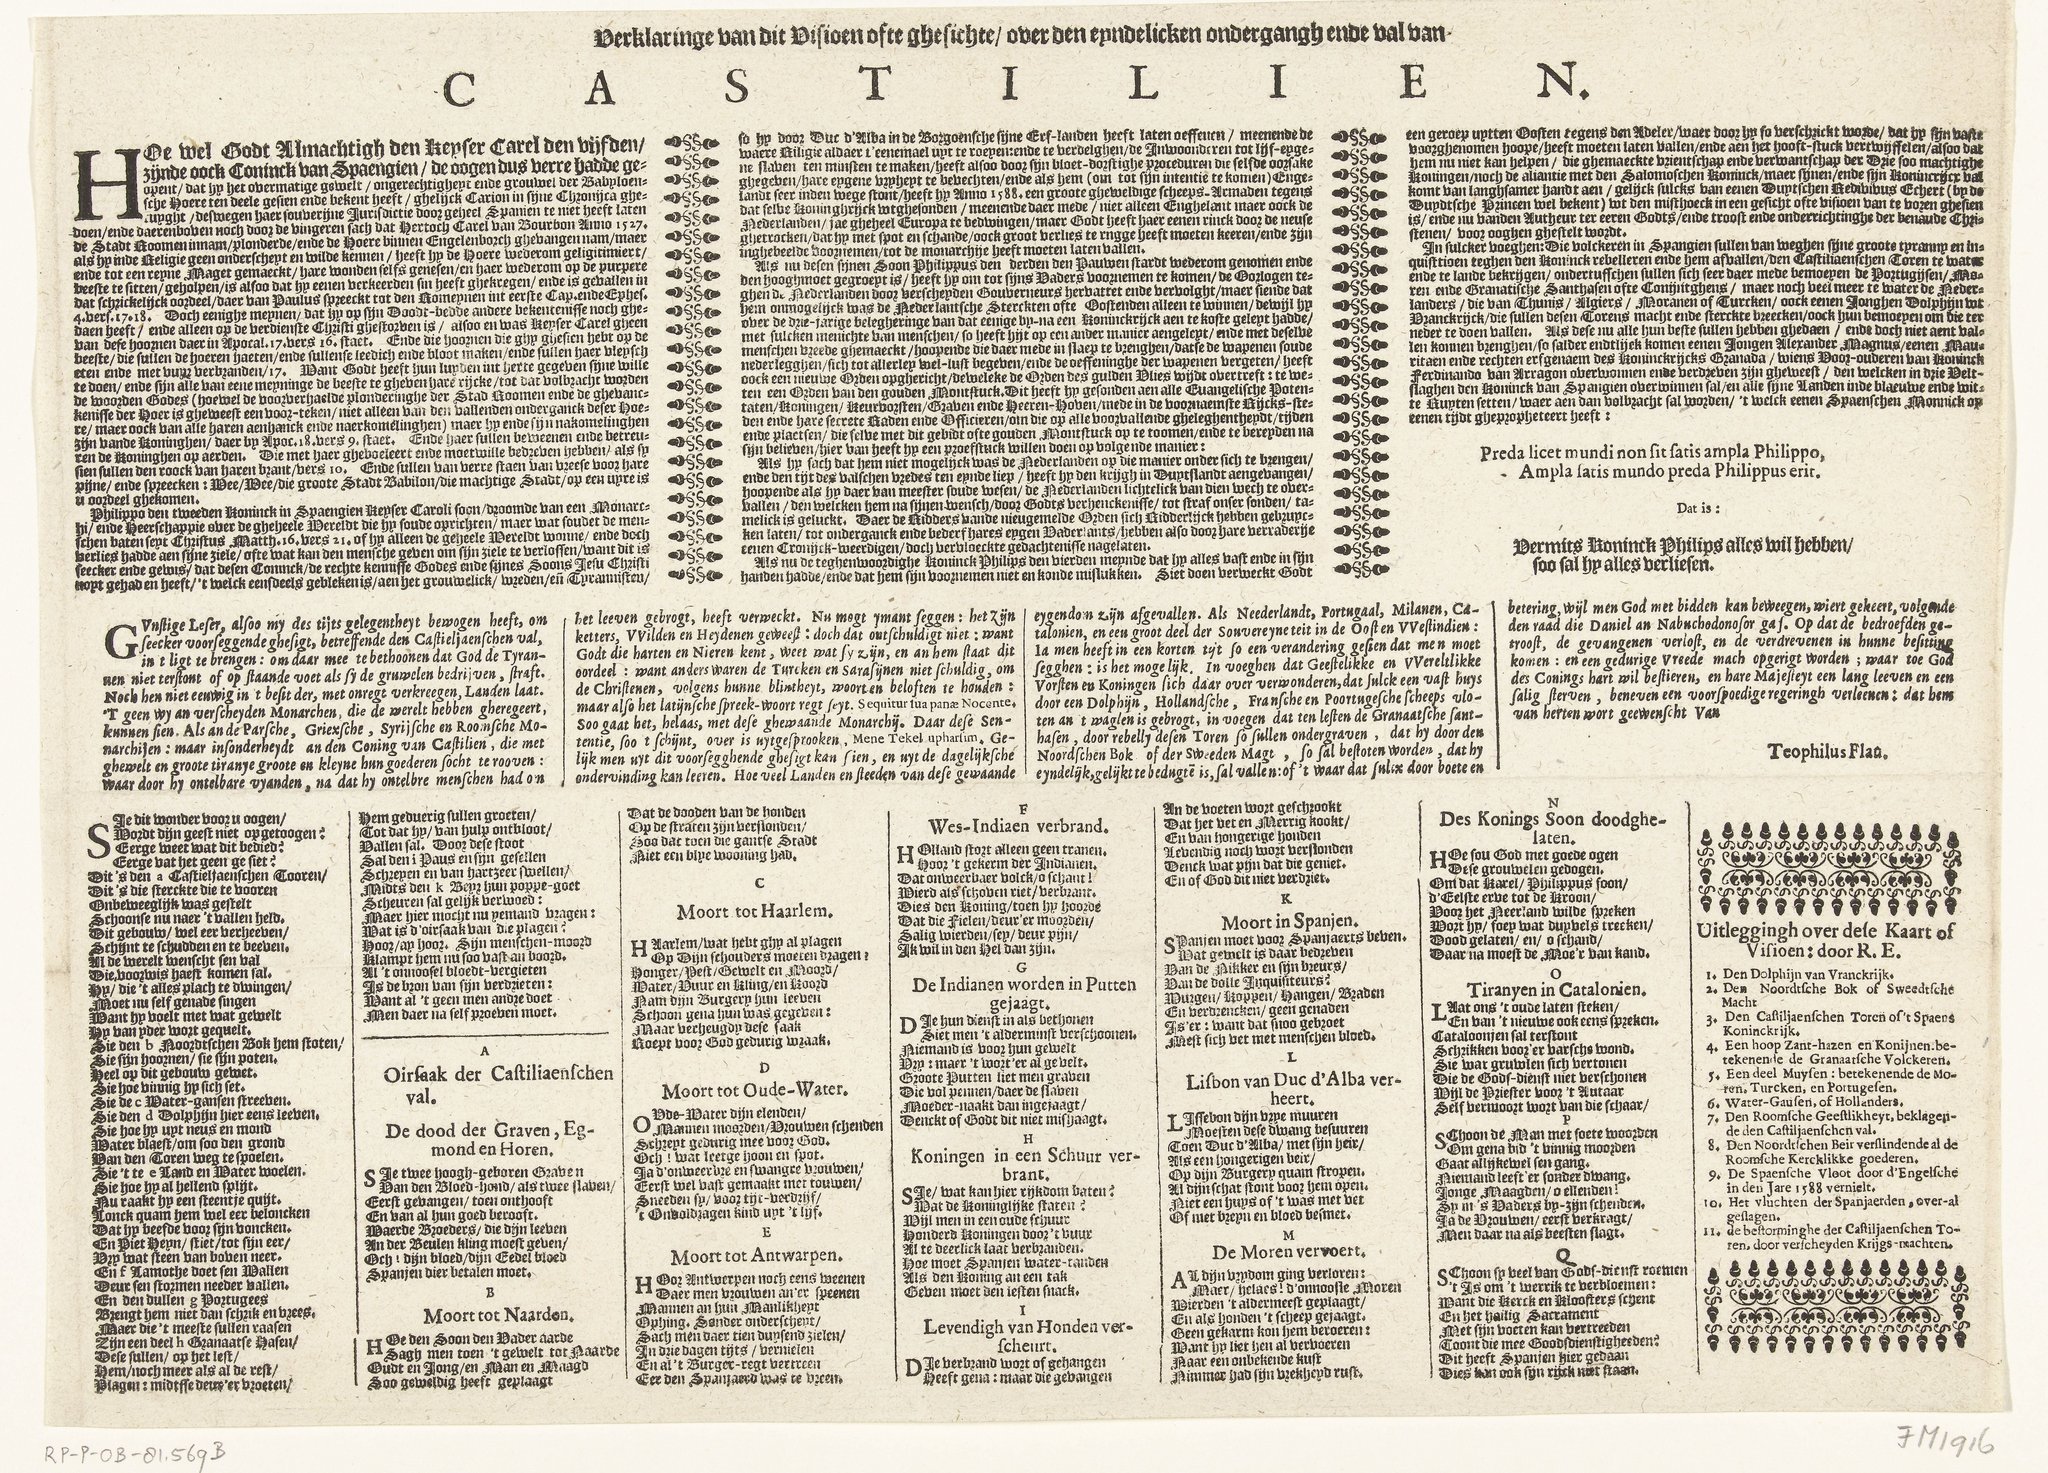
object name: text sheet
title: Tekstblad bij de prent van het visioen van de ondergang van Spanje, ca. 1630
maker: Anonymous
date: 1630-1635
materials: paper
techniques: letterpress printing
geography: northern netherlands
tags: filips iv (koning van spanje)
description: Muller ordende deze plaat eerst bij het jaar 1645. Volgens de beschrijving in het Supplement past de prent beter rond 1625 omdat de prent gebaseerd zou zijn op (of het origineel voor) de titelprent in: Nicolaas Jansz van Wassenaar, t' Achste deel of t' Vervolch van het Historisch Verhael aller gedenckwaerdiger geschiedenissen, die in Europa, als Duijtslant, Vranckrijck, Engelant ... Nederlant: in Asia ... in Africa ... in America ... van Octobri des jaers 1624. tot April des jaers 1625. voorgevallen syn, Johannes Janssonius, Amsterdam 1625 (FMH 1433A/8). De identificatie in de prent van de Noordse Bok als Zweden wijst op een datering van ca. 1630. De verklaring in cursief is gesigneerd door: Teophilius Flaû. De legenda is door: R.E.